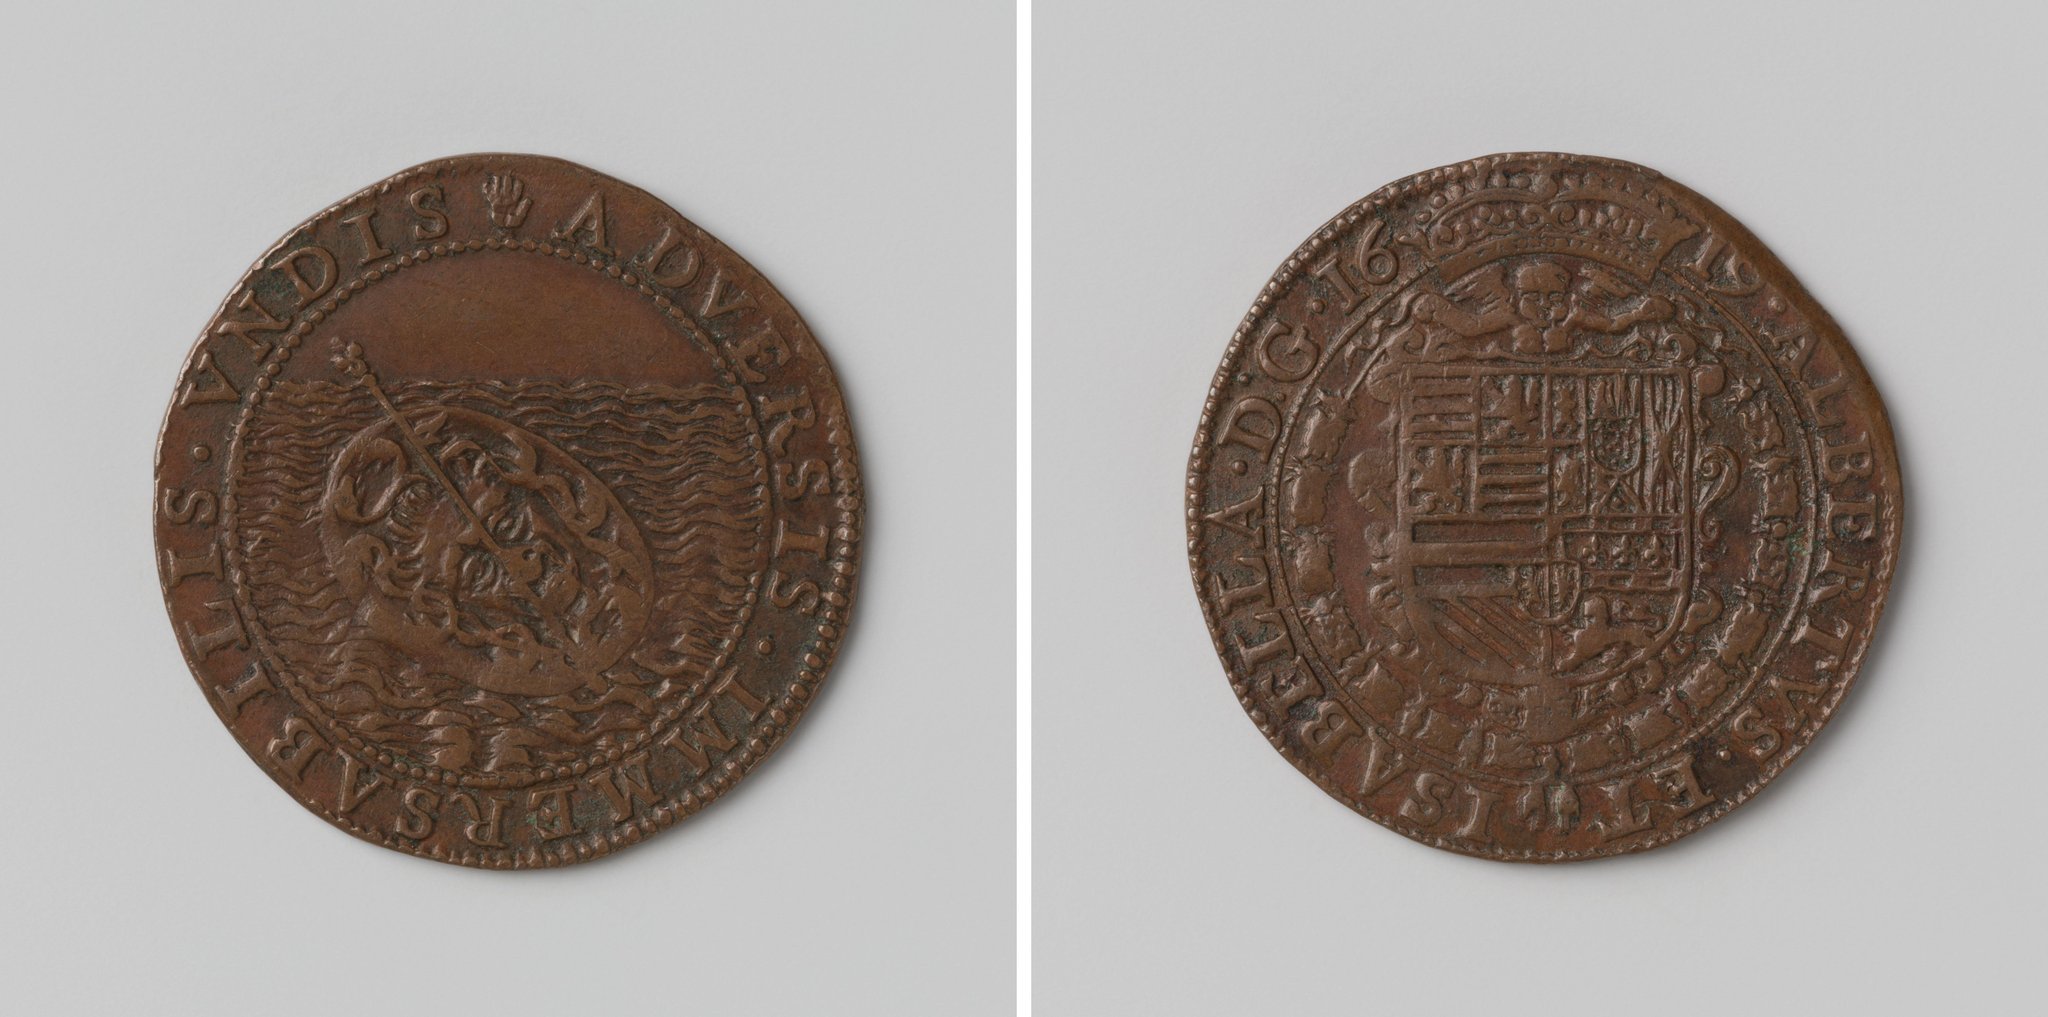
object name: jeton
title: Steun van Albrecht en Isabella van Oostenrijk aan Ferdinand II, Duits keizer, in de oorlog tegen Bohemen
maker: Anonymous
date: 1619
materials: copper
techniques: striking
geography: antwerp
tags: vienna, ferdinand ii (duits keizer), infante van spanje isabella clara eugenia, brussels, albrecht aartshertog van oostenrijk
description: Koperen penning. Voorzijde: scepter, liggend op schild met afbeelding van kop van Medusa, drijft op golven van bewogen zee binnen omschrift. Keerzijde: gekroond wapenschild, omhangen met de door een engeltje vastgehouden orde van het Gulden Vlies binnen omschrift